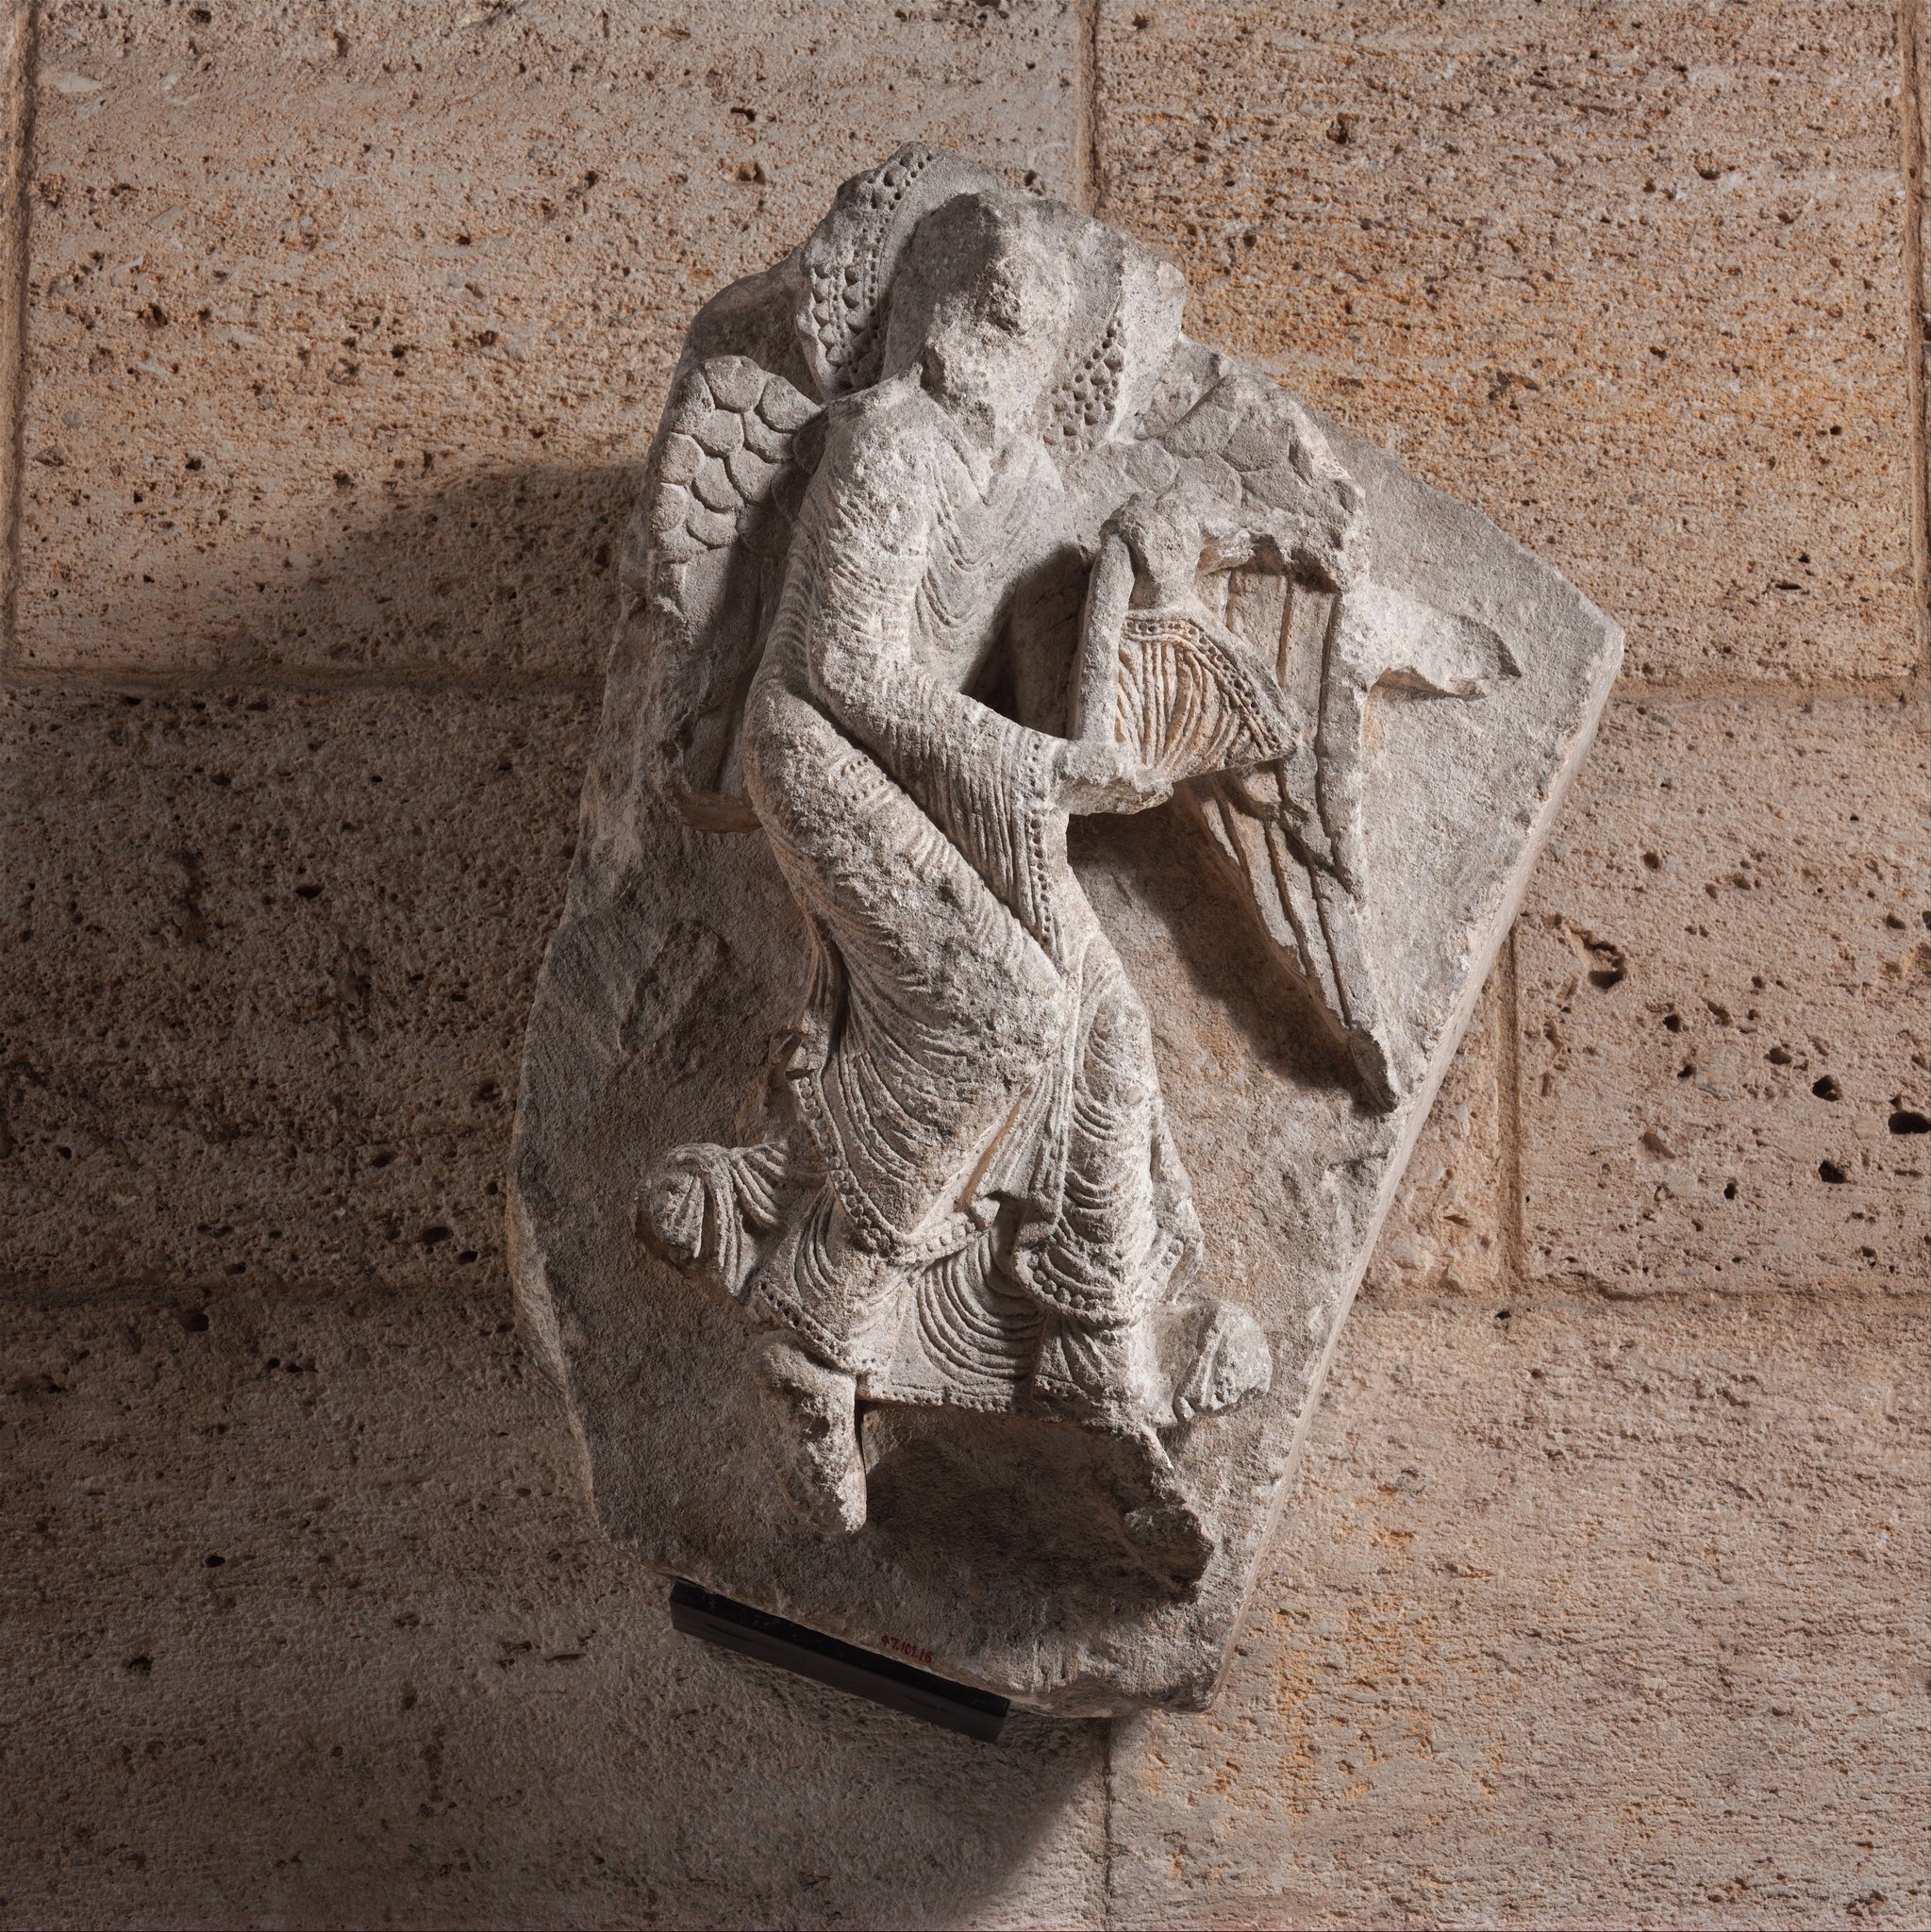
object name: voussoir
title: Angel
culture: french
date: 1130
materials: limestone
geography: france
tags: angels